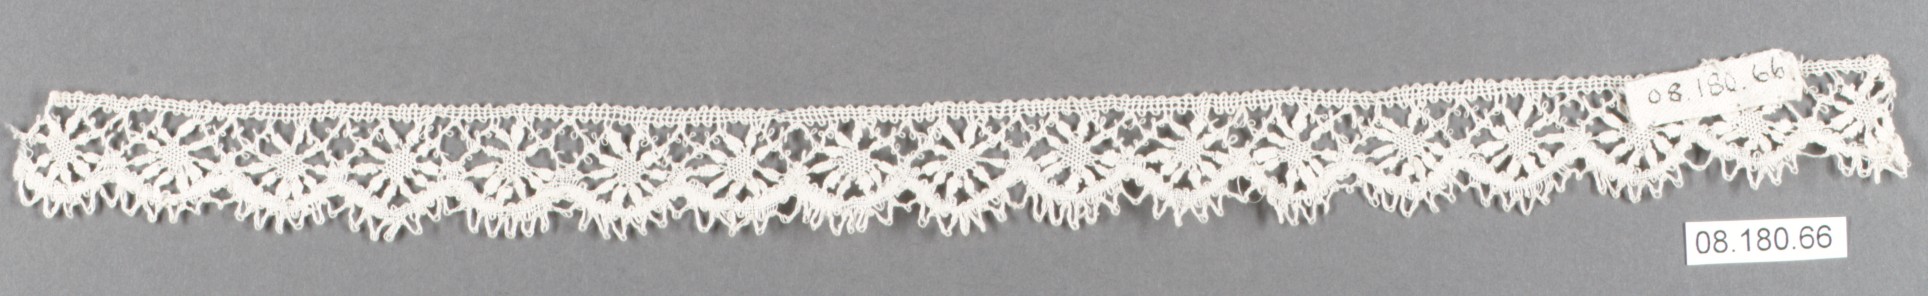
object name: fragment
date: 1801-1900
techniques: lace